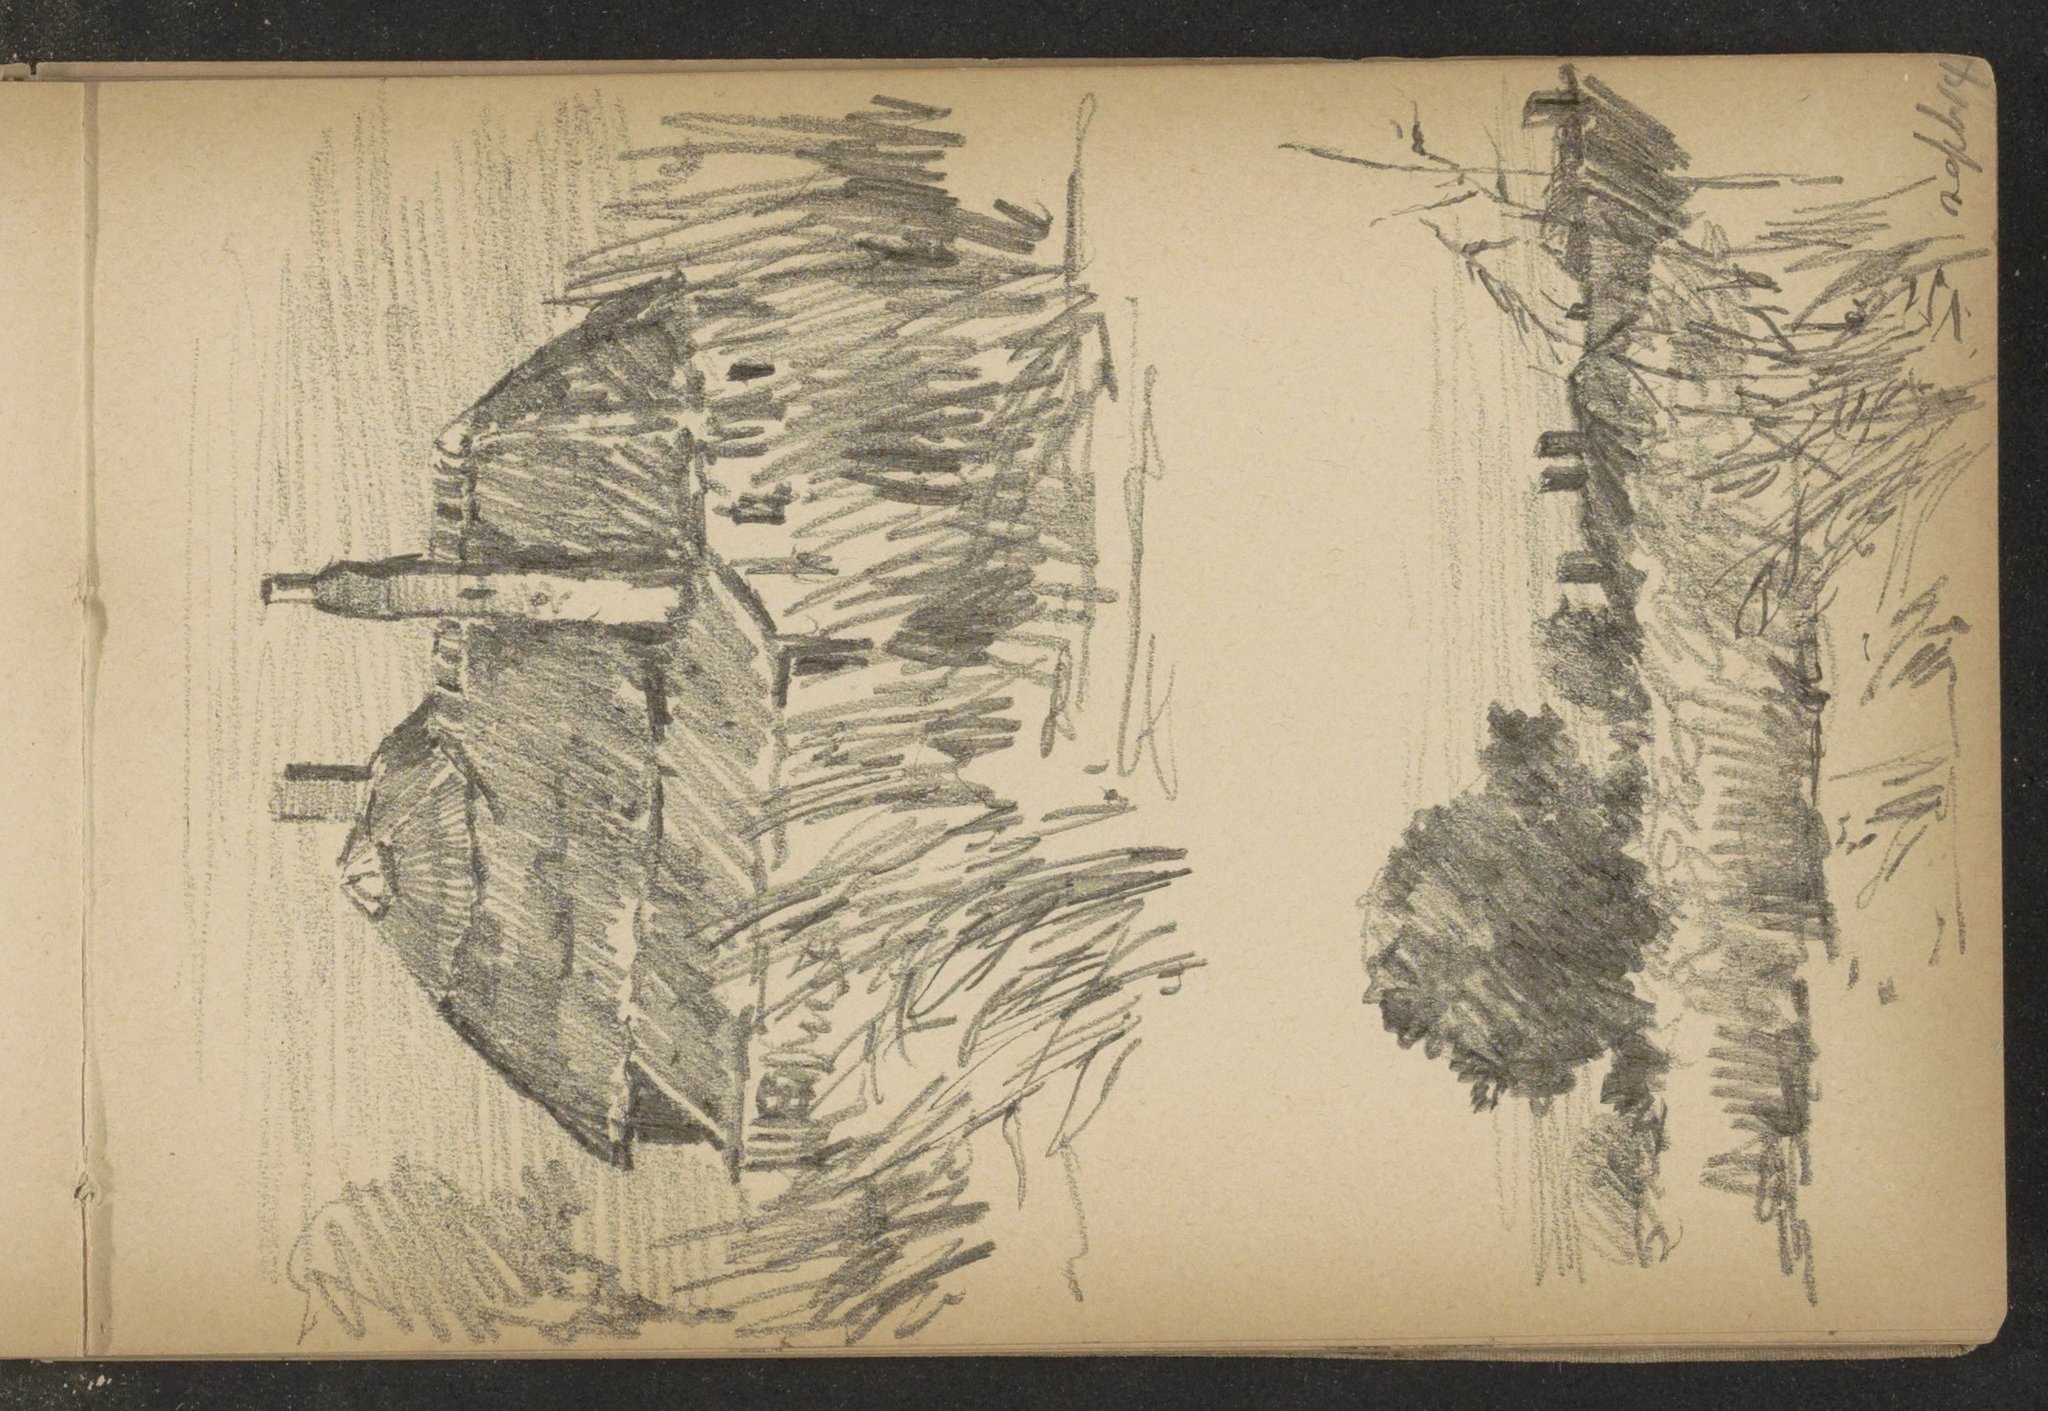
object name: sketchbook leaf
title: Boerderijen in een landschap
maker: alexander shilling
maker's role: draughtsman, print maker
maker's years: 1859-1937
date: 1809-1888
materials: paper, pencil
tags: farm or solitary house in landscape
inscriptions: date: ‘sept 14’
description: Blad 19 recto uit een schetsboek met 34 bladen.